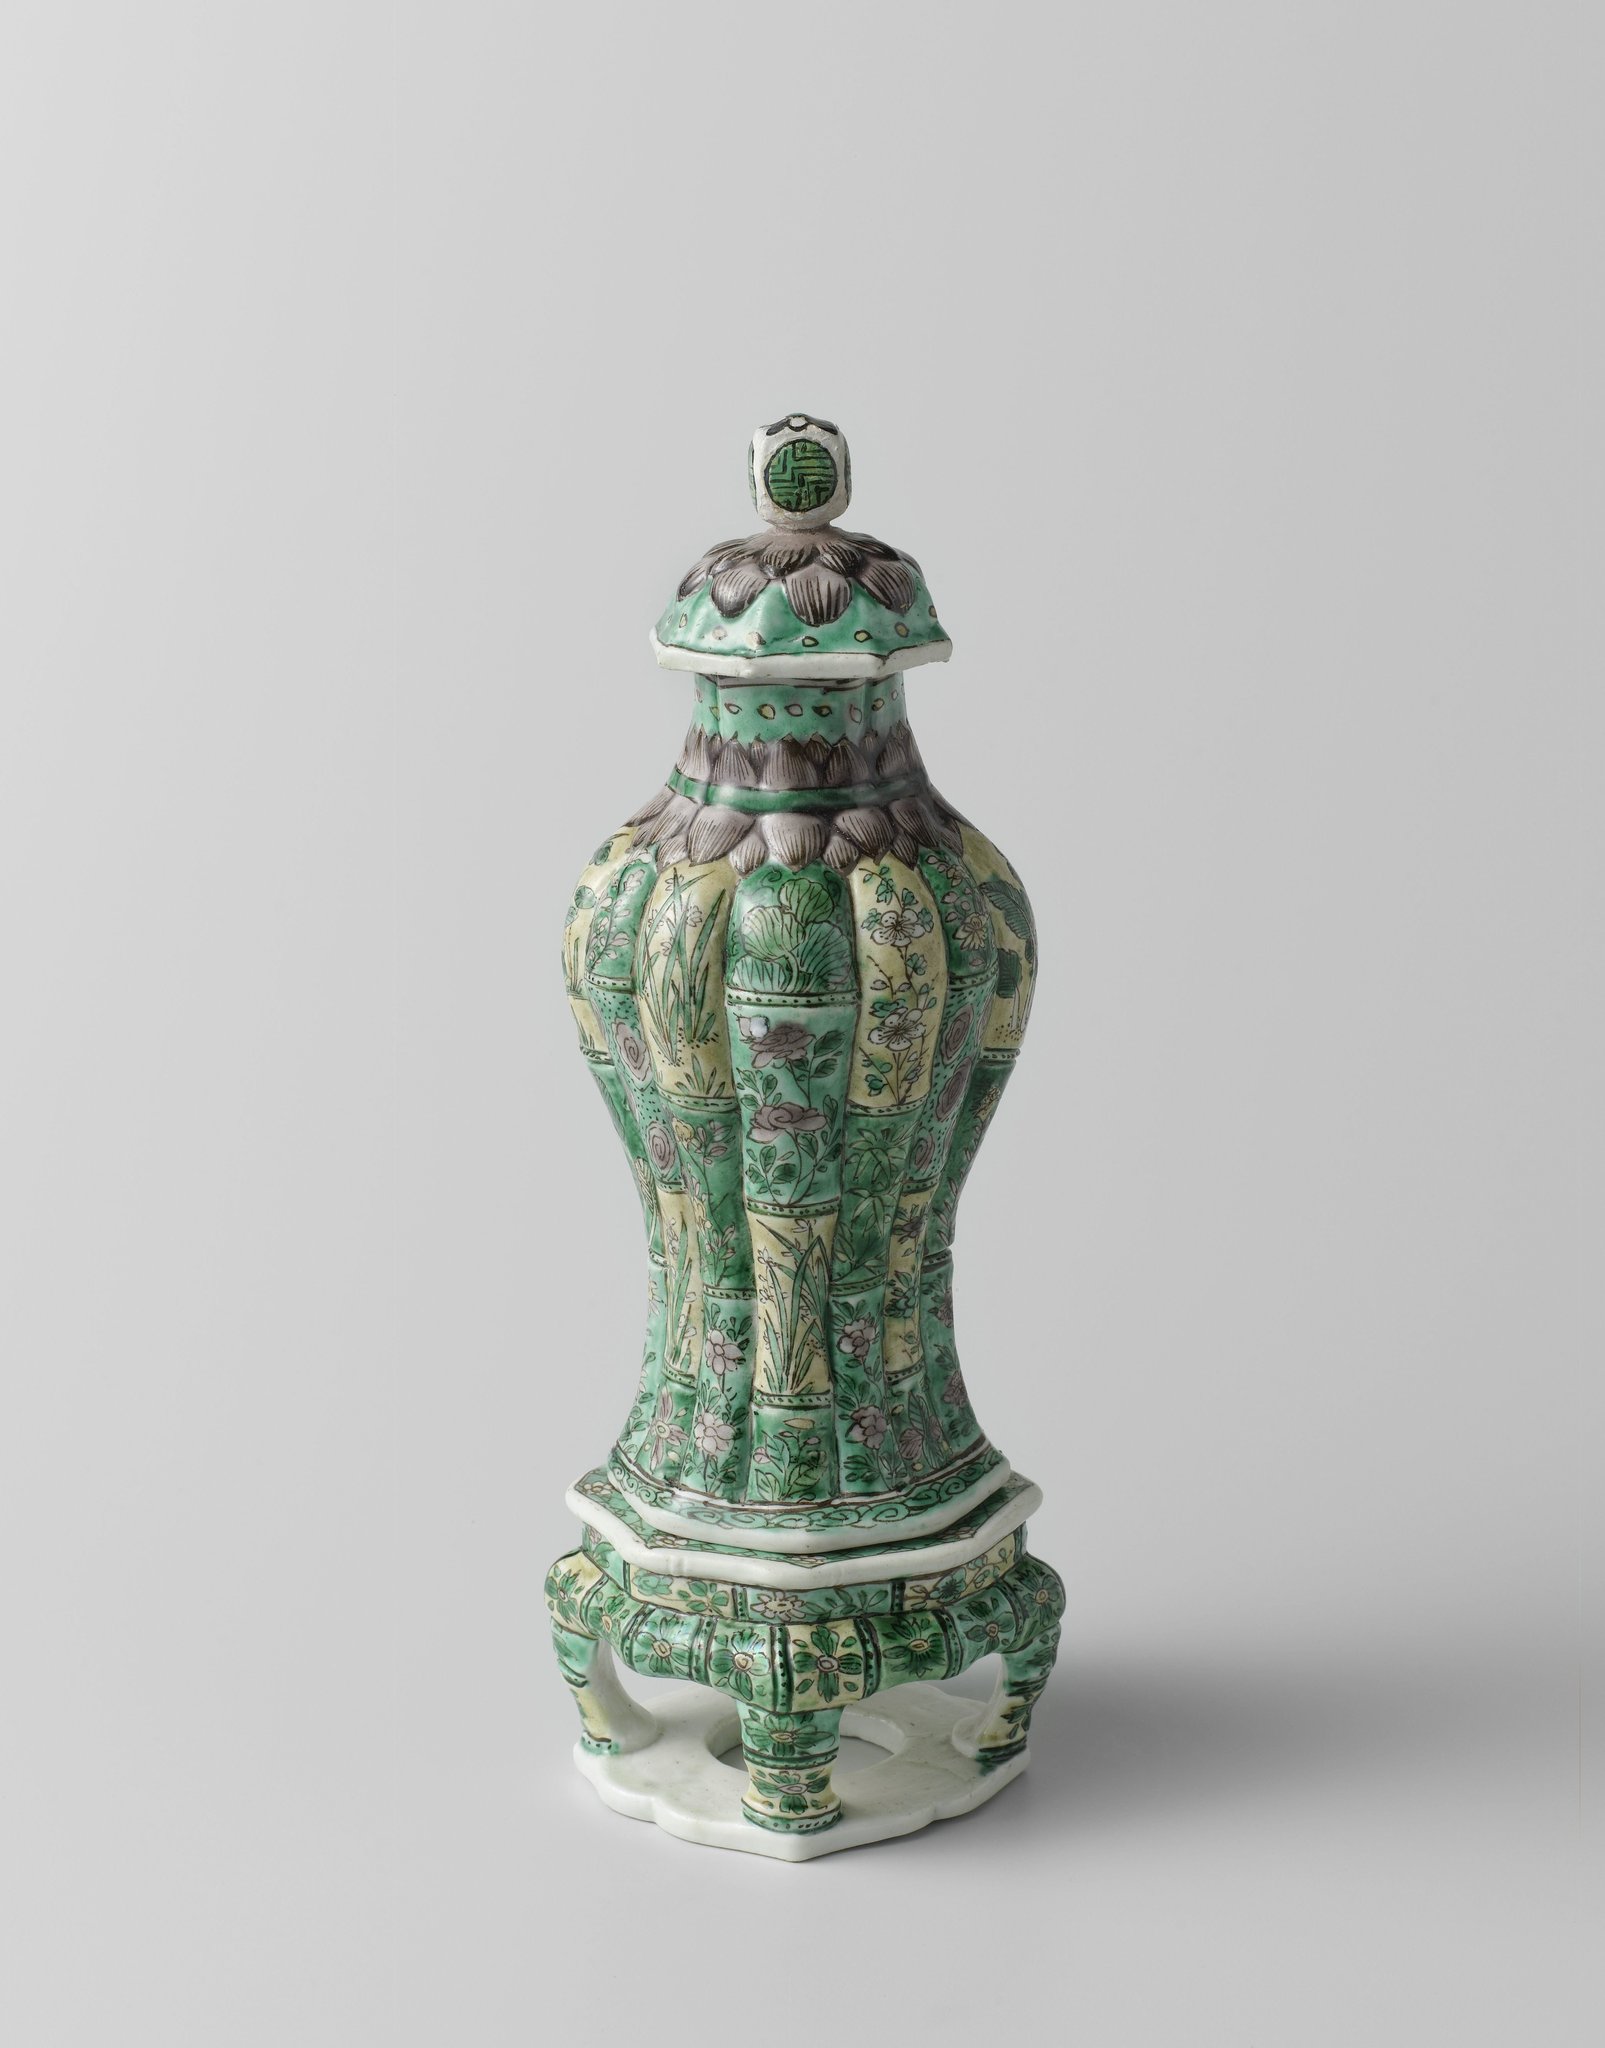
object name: vase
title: Covered vase with stand, modelled in bamboo-shaped sections with flower sprays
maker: Anonymous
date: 1700-1724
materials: glaze, paint, porcelain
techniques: forming, turning, vitrification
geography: china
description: Vaas van porselein, beschilderd op het glazuur in groen, geel, aubergine en zwart. Gemodelleerd in bamboevormige segmenten. De segmenten zijn onderverdeeld in vakken gevuld met bloemtakken, bloeiende planten of bladeren. Op de nek en schouder van de vaas een band met gemodelleerde lotusbladeren. Email sur biscuit met famille verte kleuren.